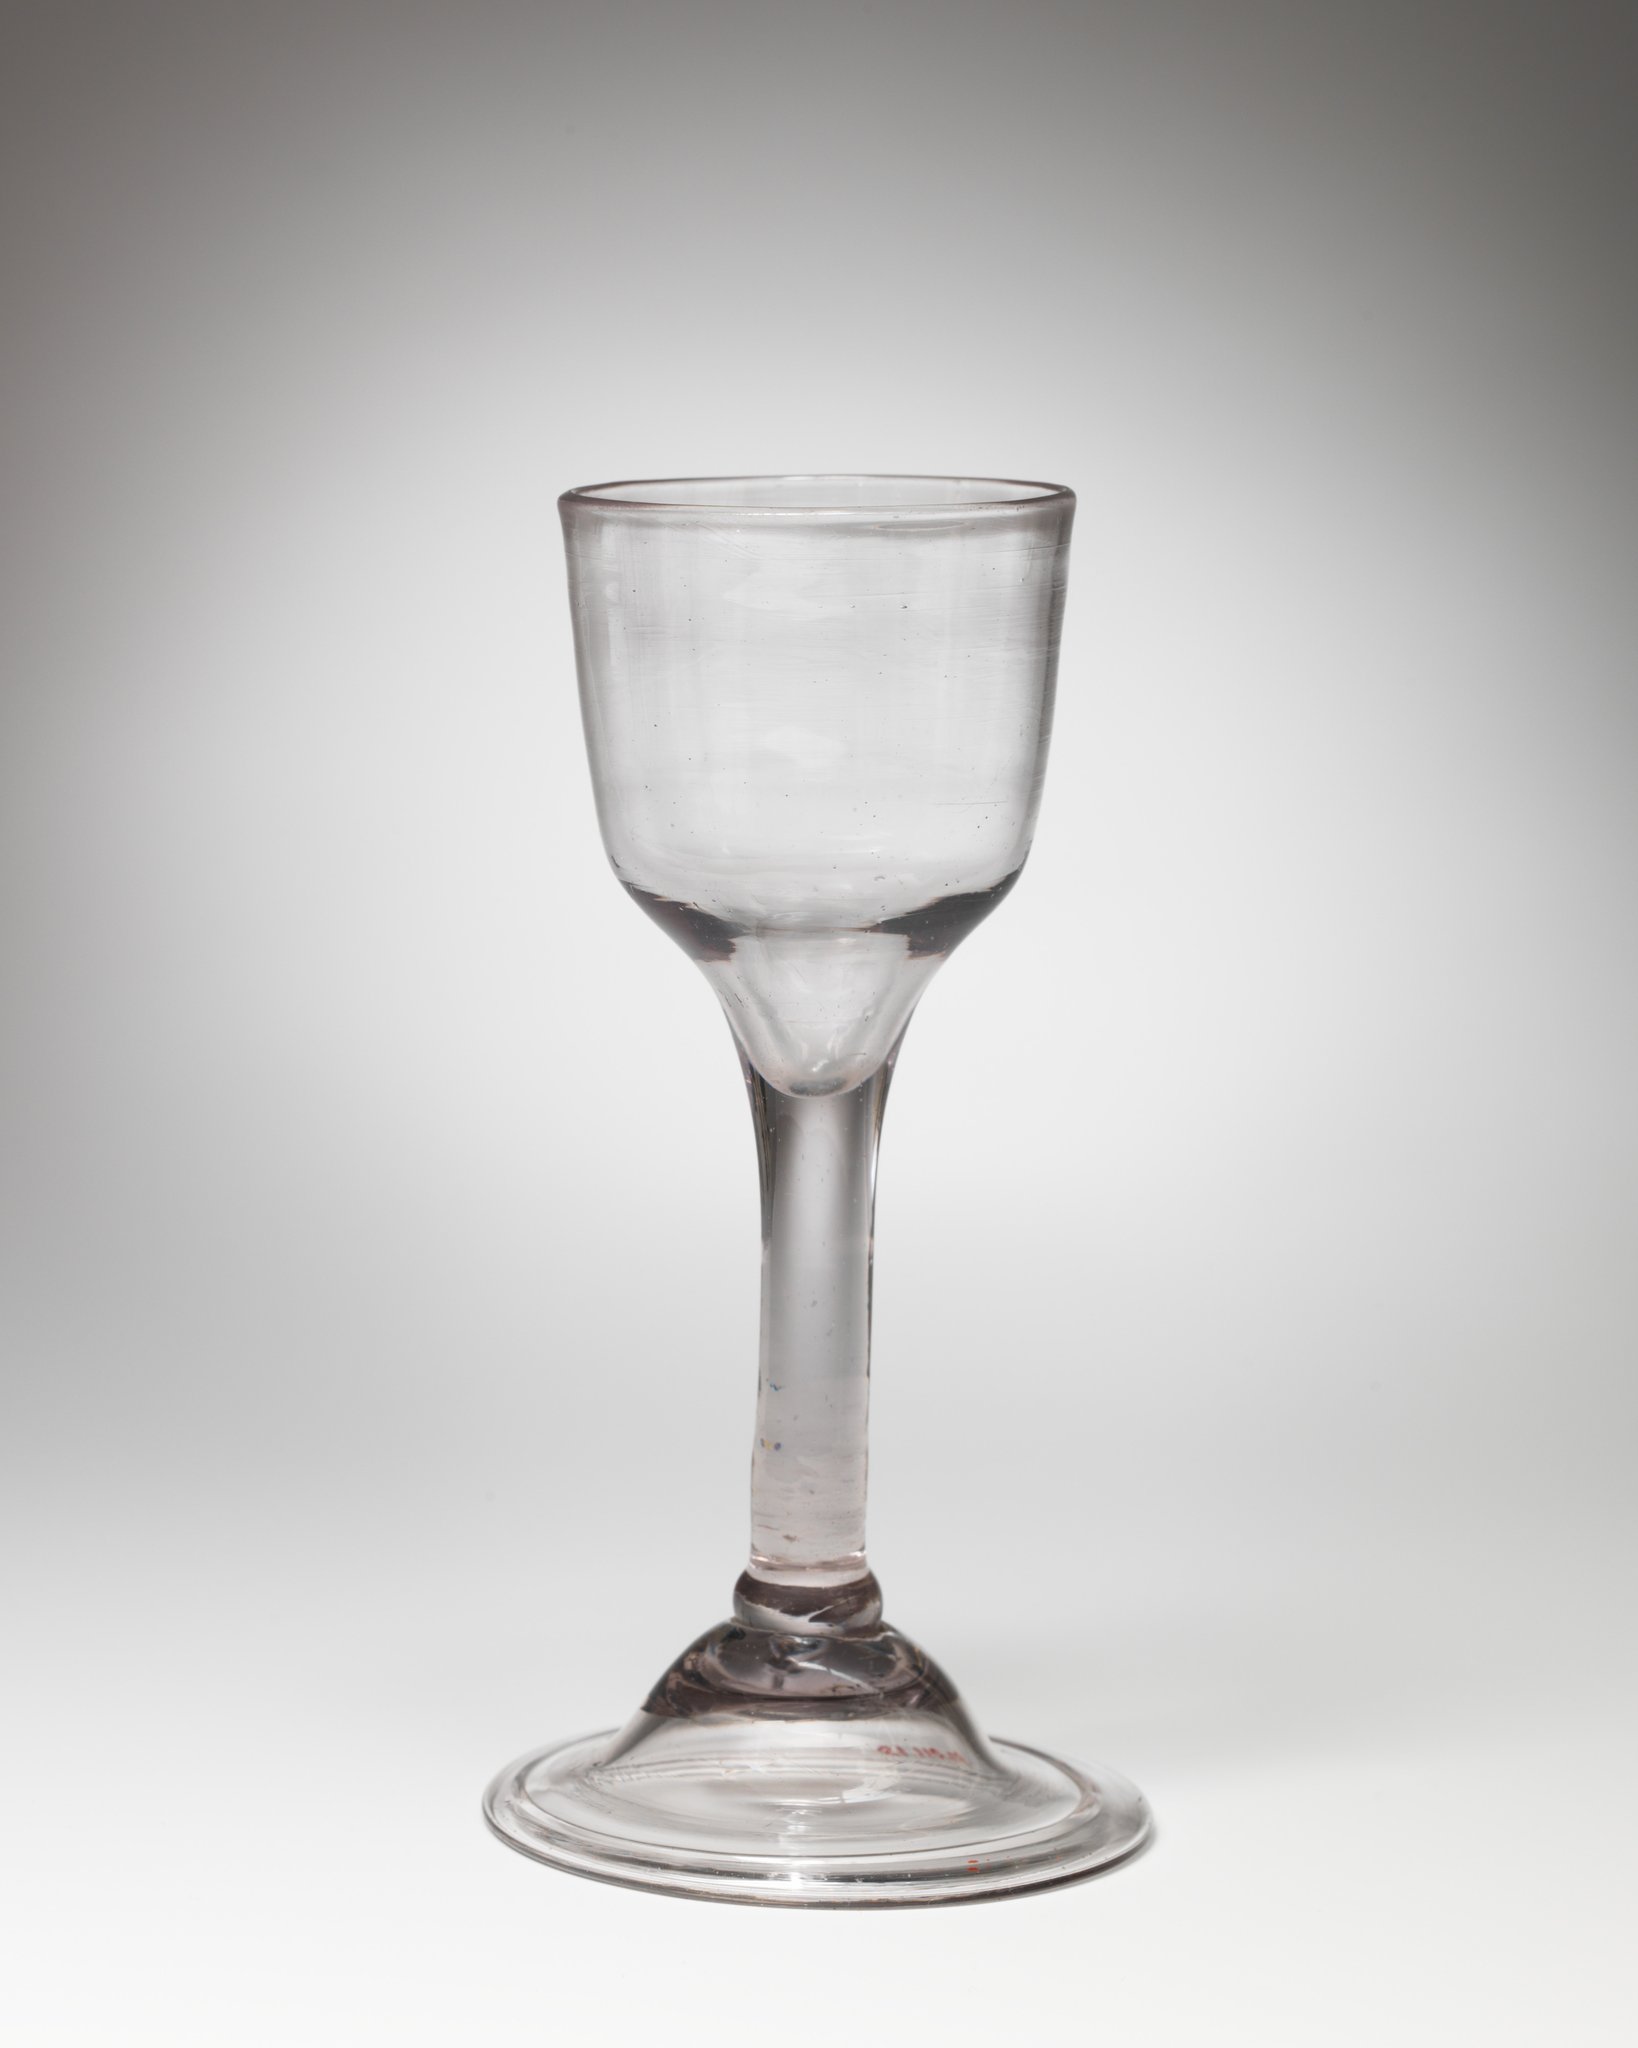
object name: wineglass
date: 1730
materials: glass